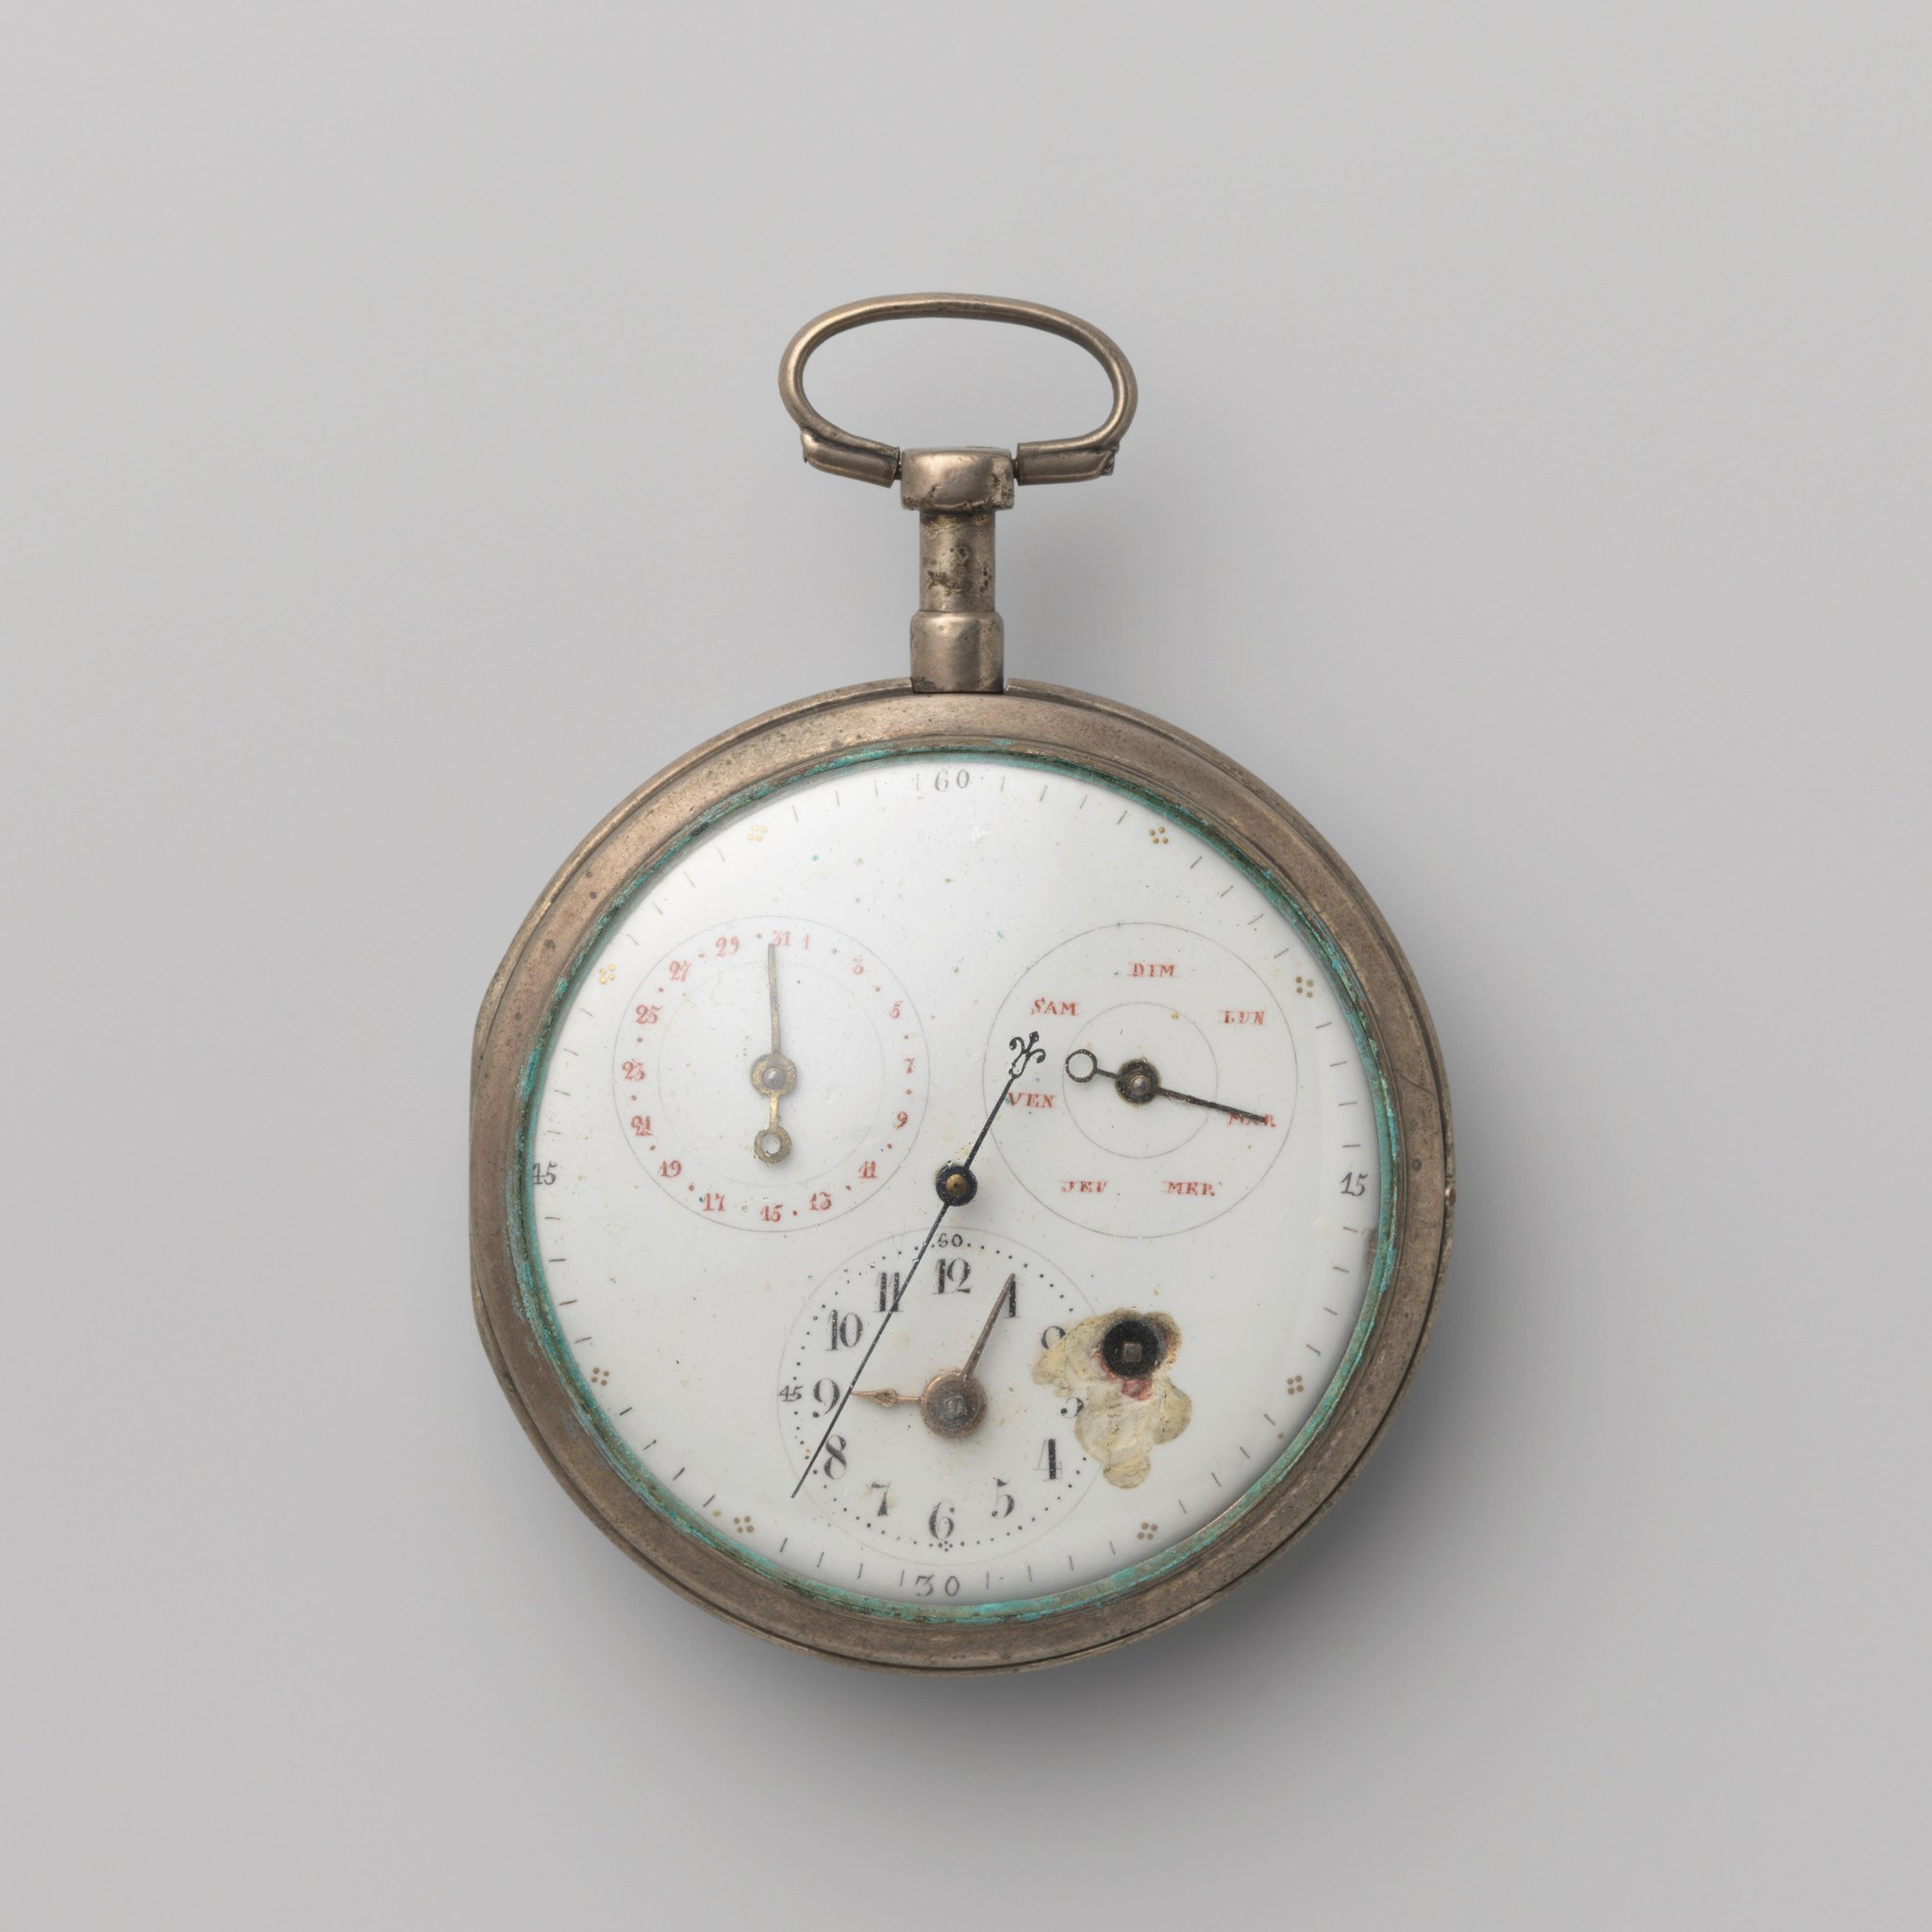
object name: wrist watch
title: Herenhorloge van zilver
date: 1820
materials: silver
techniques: enameling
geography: france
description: Herenhorloge van zilver met gladde achterbodem en witgeëmailleerde wijzerplaat met 3 cijferringen.